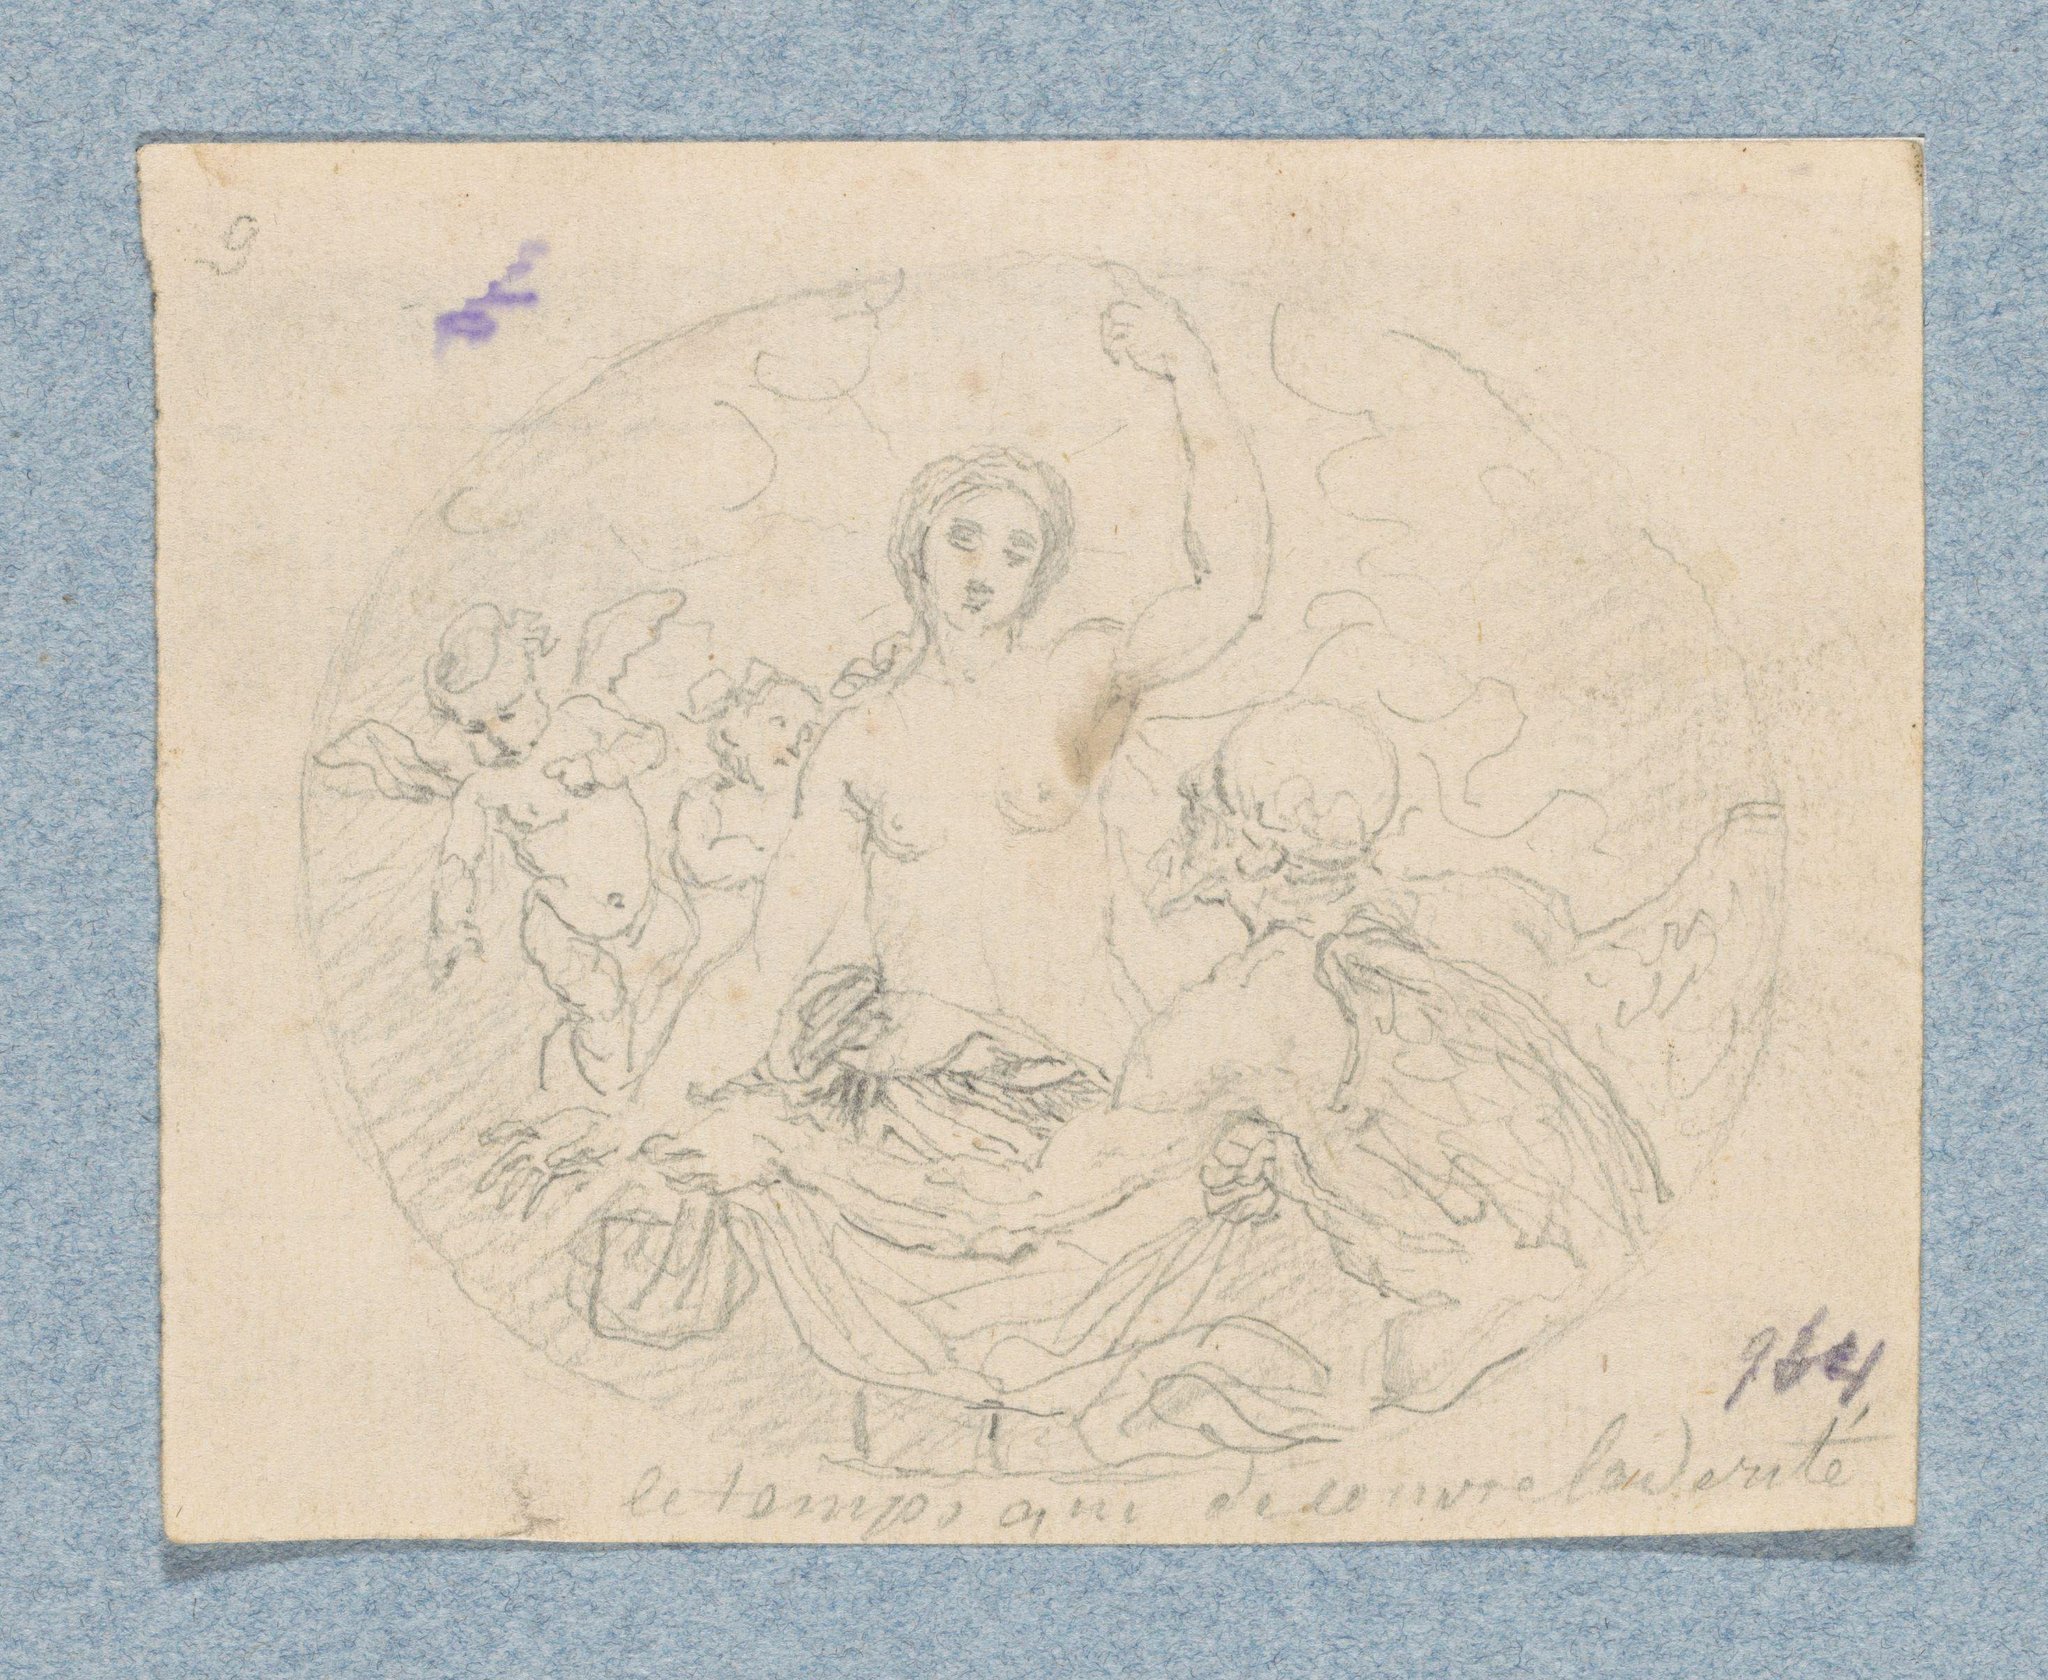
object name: drawing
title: Tijd onthult de Waarheid (in doos met 43 tekeningen)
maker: louis fabritius dubourg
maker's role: draughtsman, print maker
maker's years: 1693-1775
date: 1703-1775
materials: paper, pencil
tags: time denuding truth